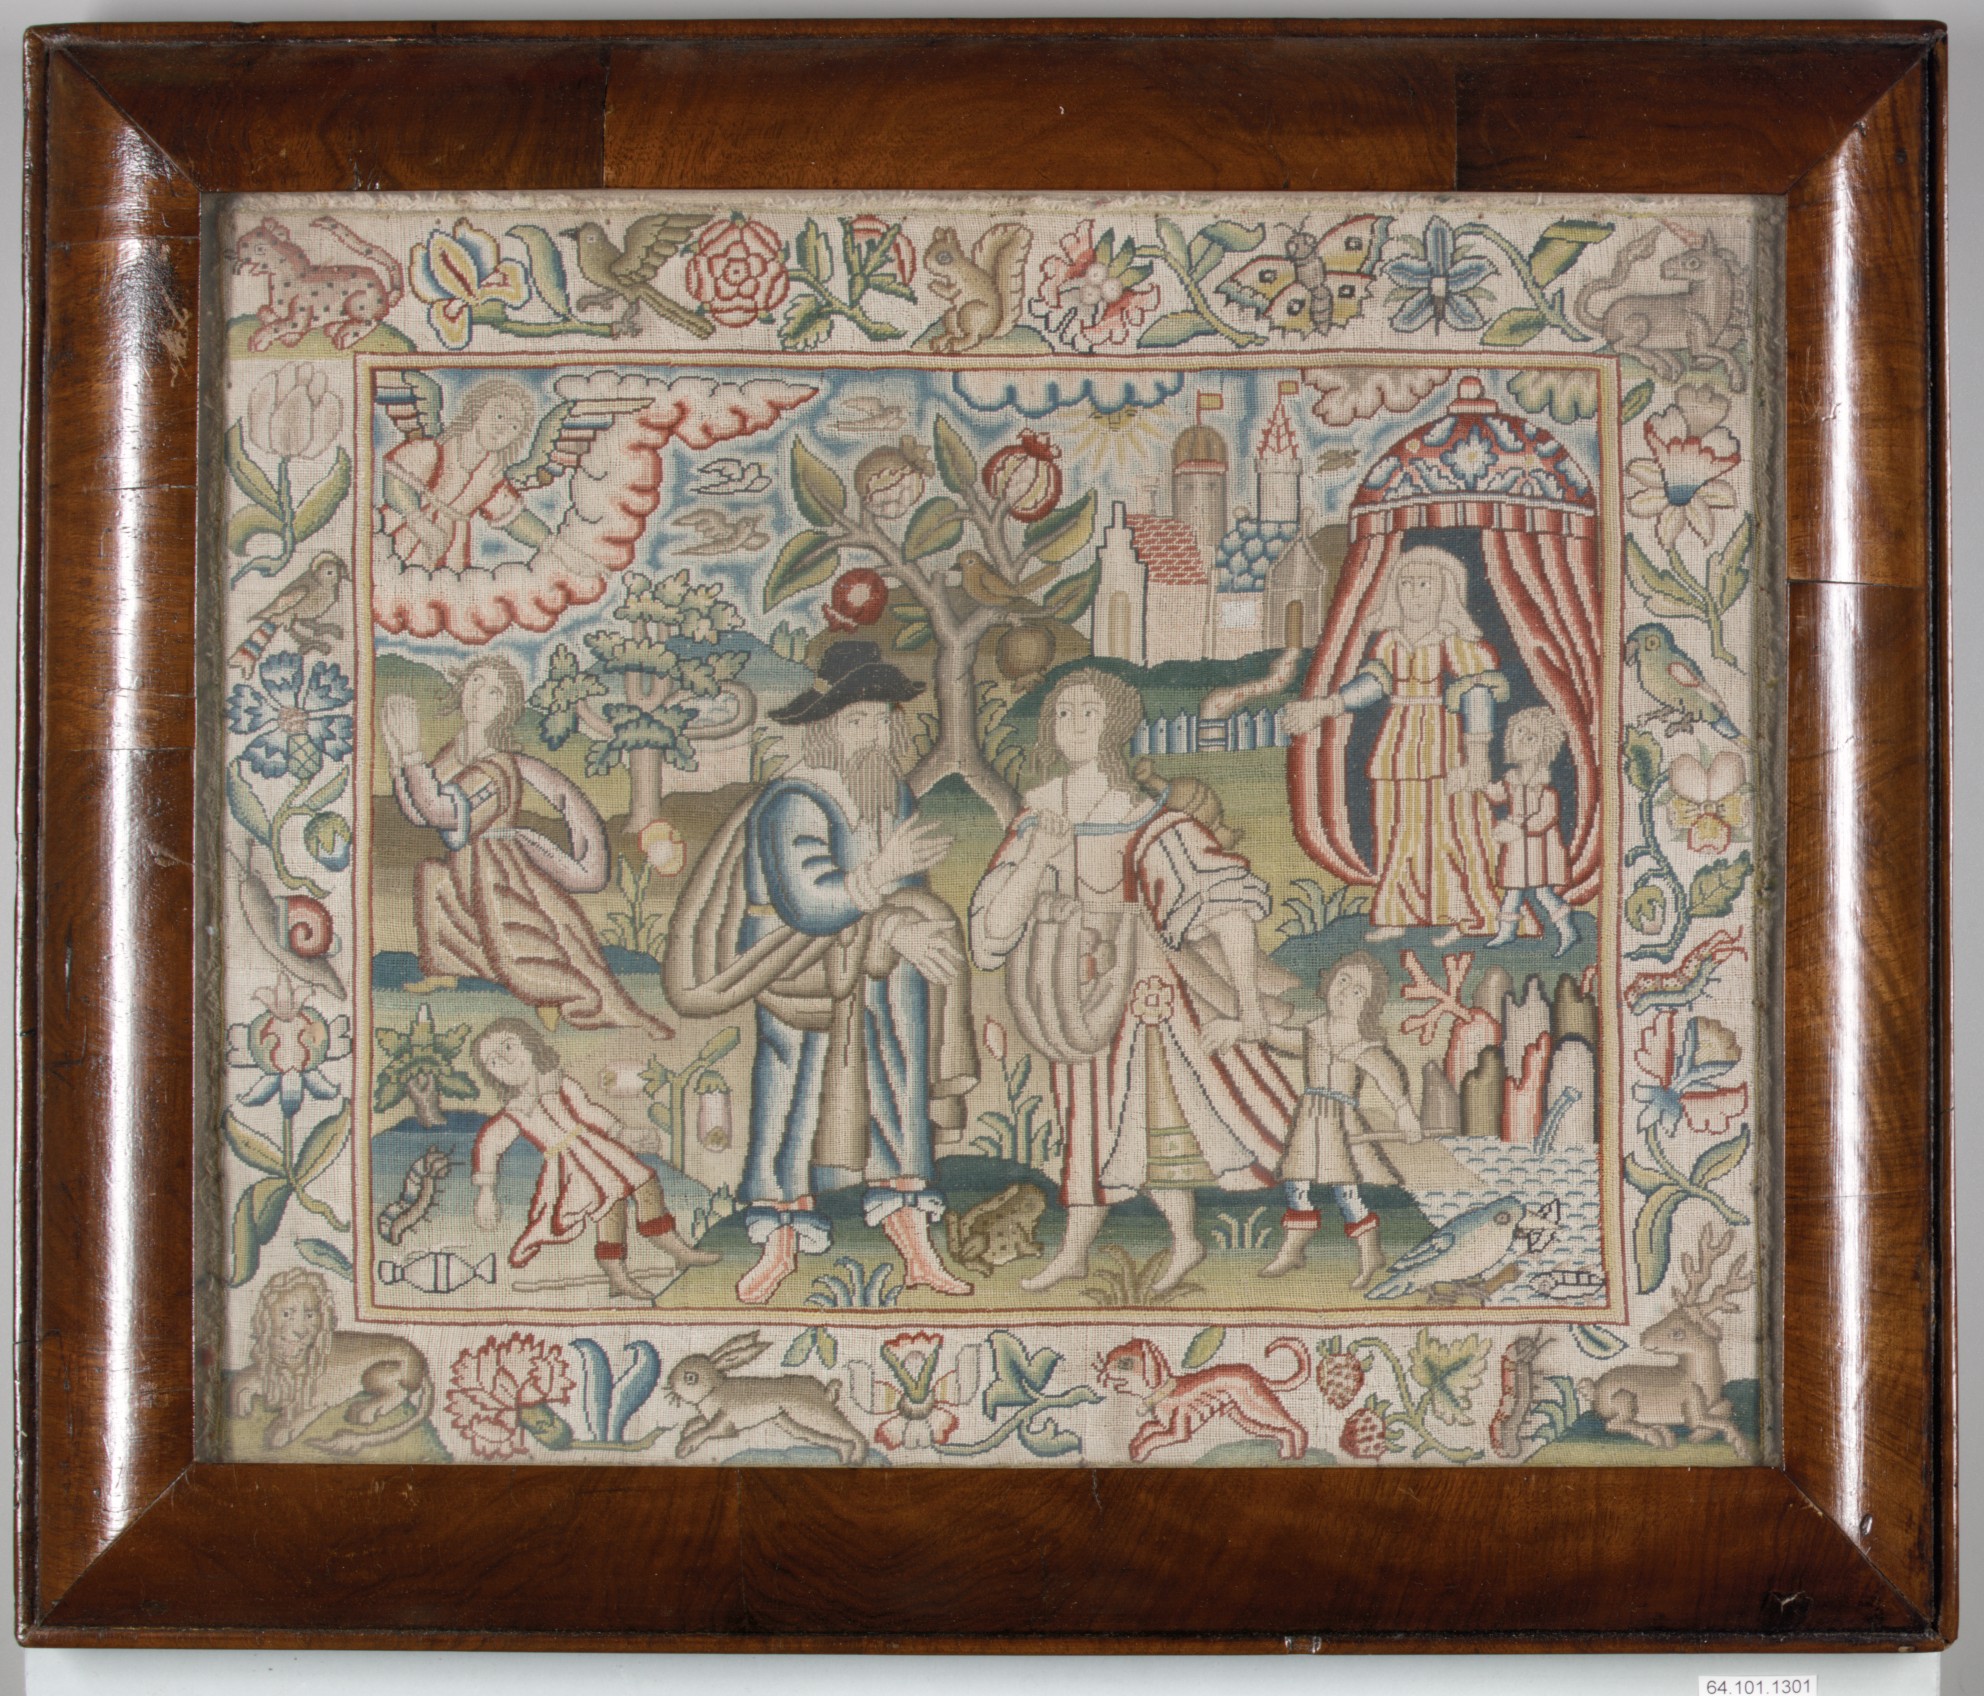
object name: embroidered picture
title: Life of Abraham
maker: gerard de jode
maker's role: artist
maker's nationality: netherlandish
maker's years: 1509-1591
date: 1651-1675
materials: canvas, silk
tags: birds,men,women,unicorns,deer,dogs,frogs,butterflies,lions,rabbits,squirrels,angels,abraham